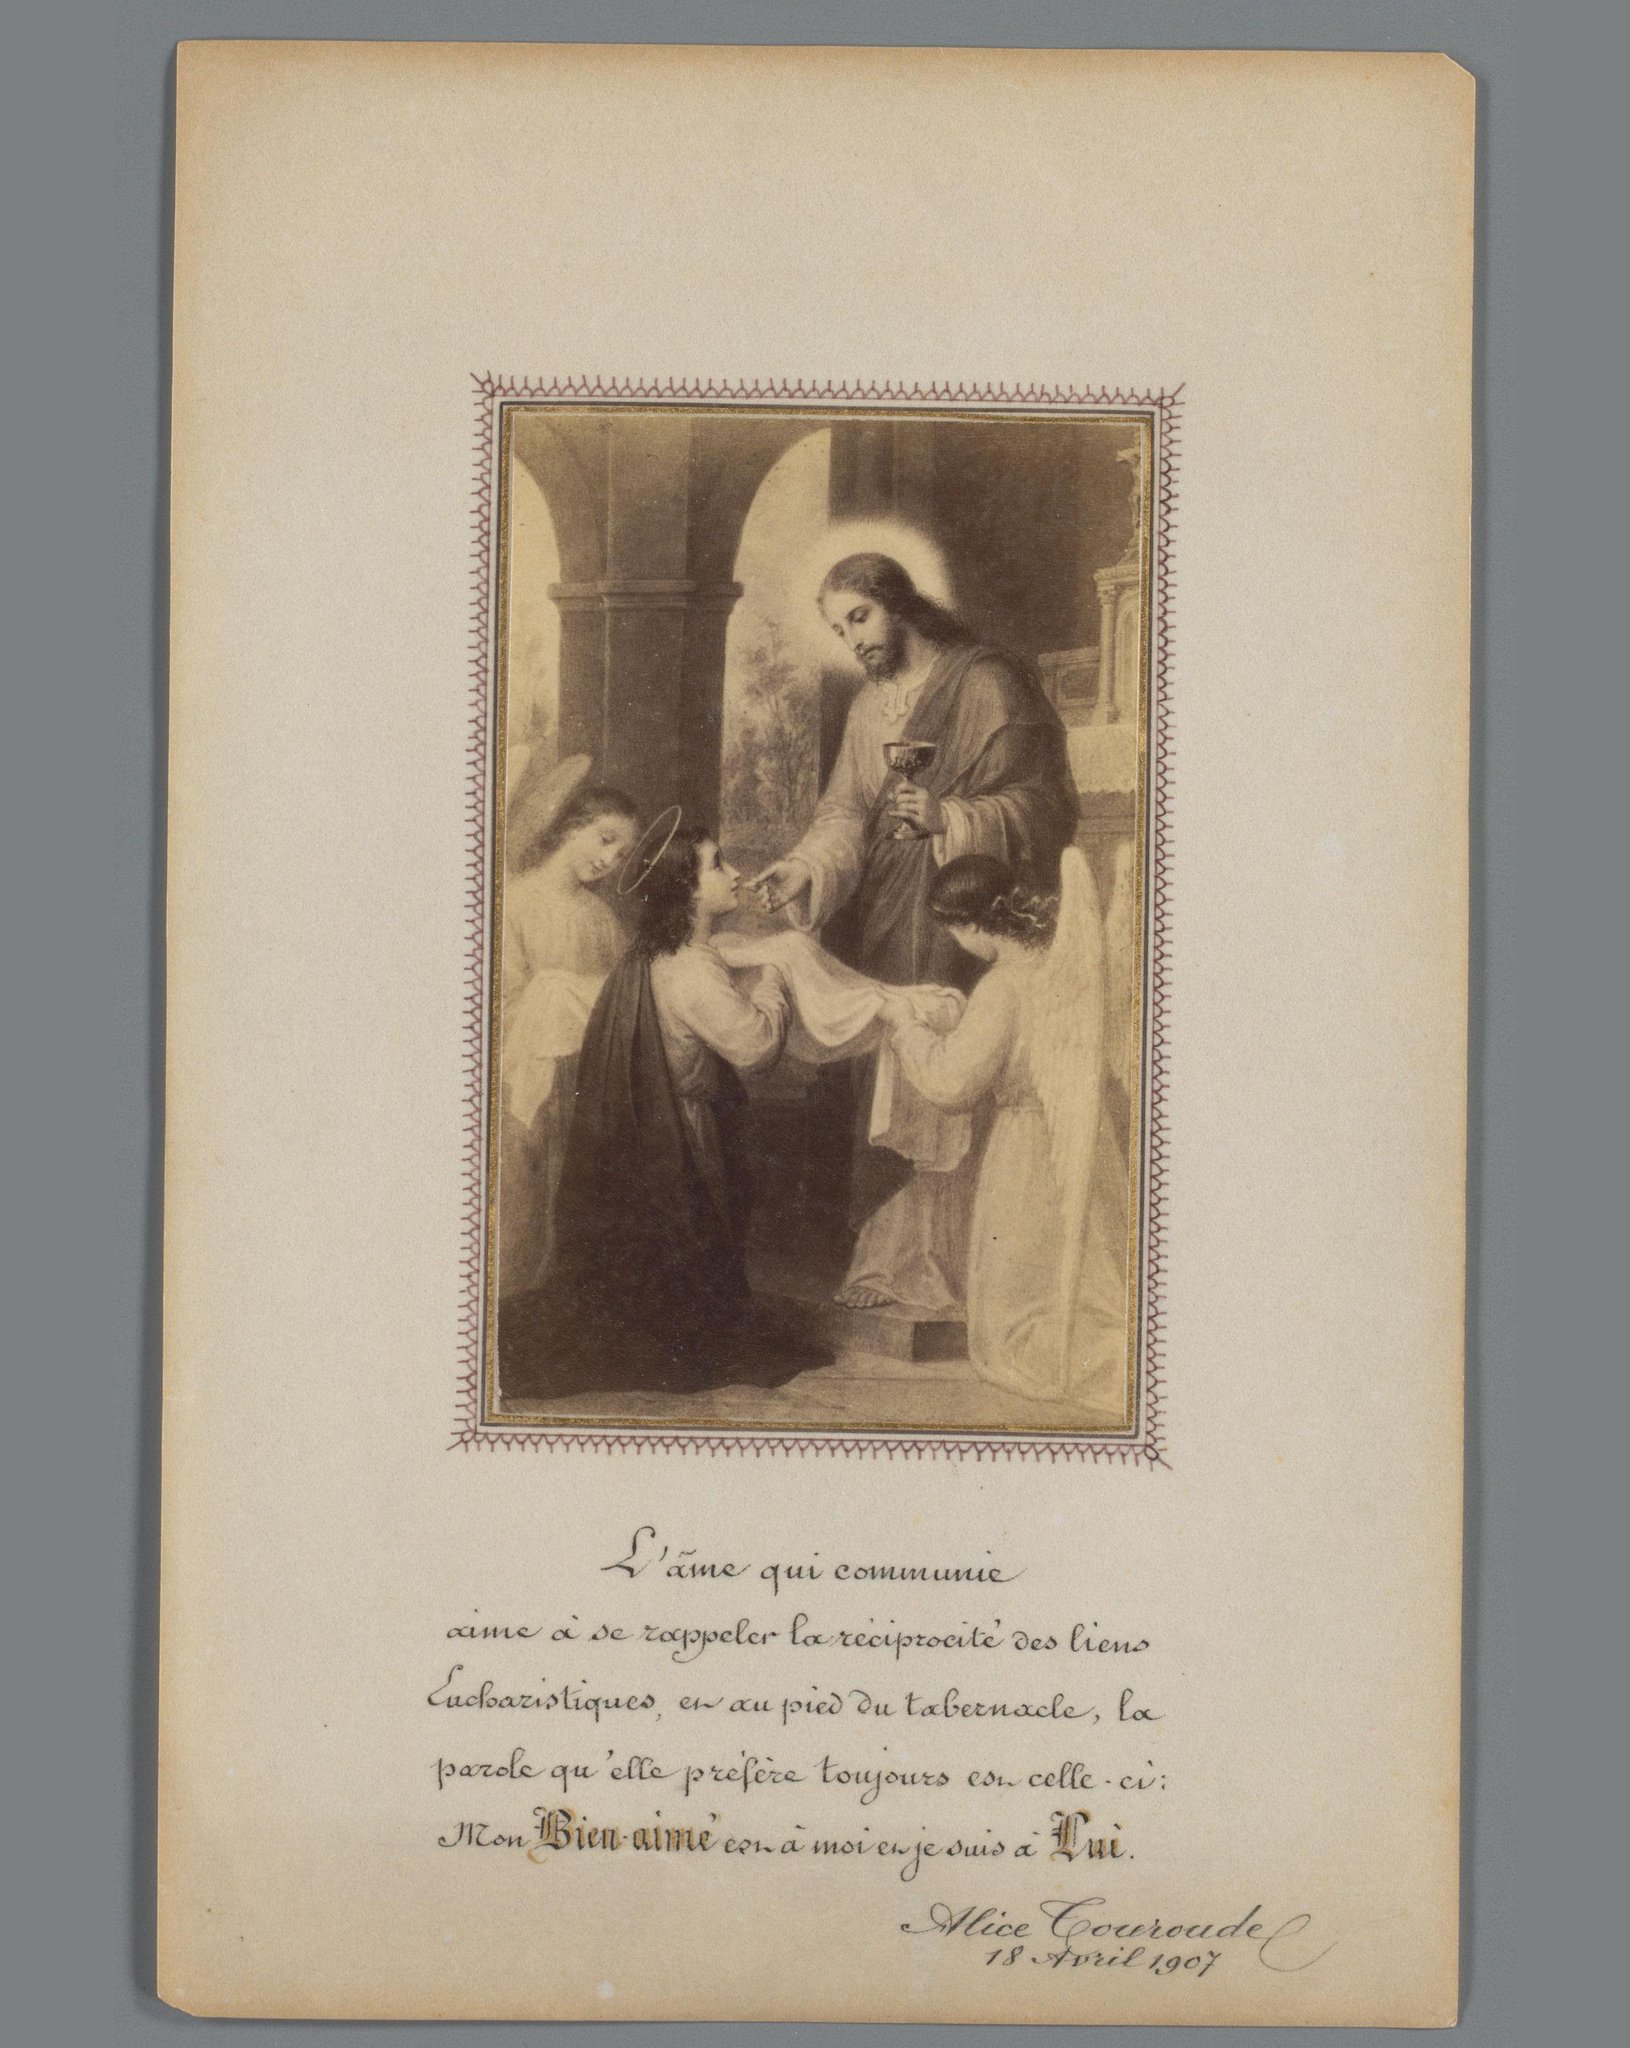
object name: photograph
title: L' áme qui communie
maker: Anonymous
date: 1907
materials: cardboard, celluloid, paper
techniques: albumen print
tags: christ with chalice, and bread or host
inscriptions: inscription: ‘L' áme qui communie/ aime à se rappeler la rèciprocité des liens/ (...)’, inscription: ‘€5-’